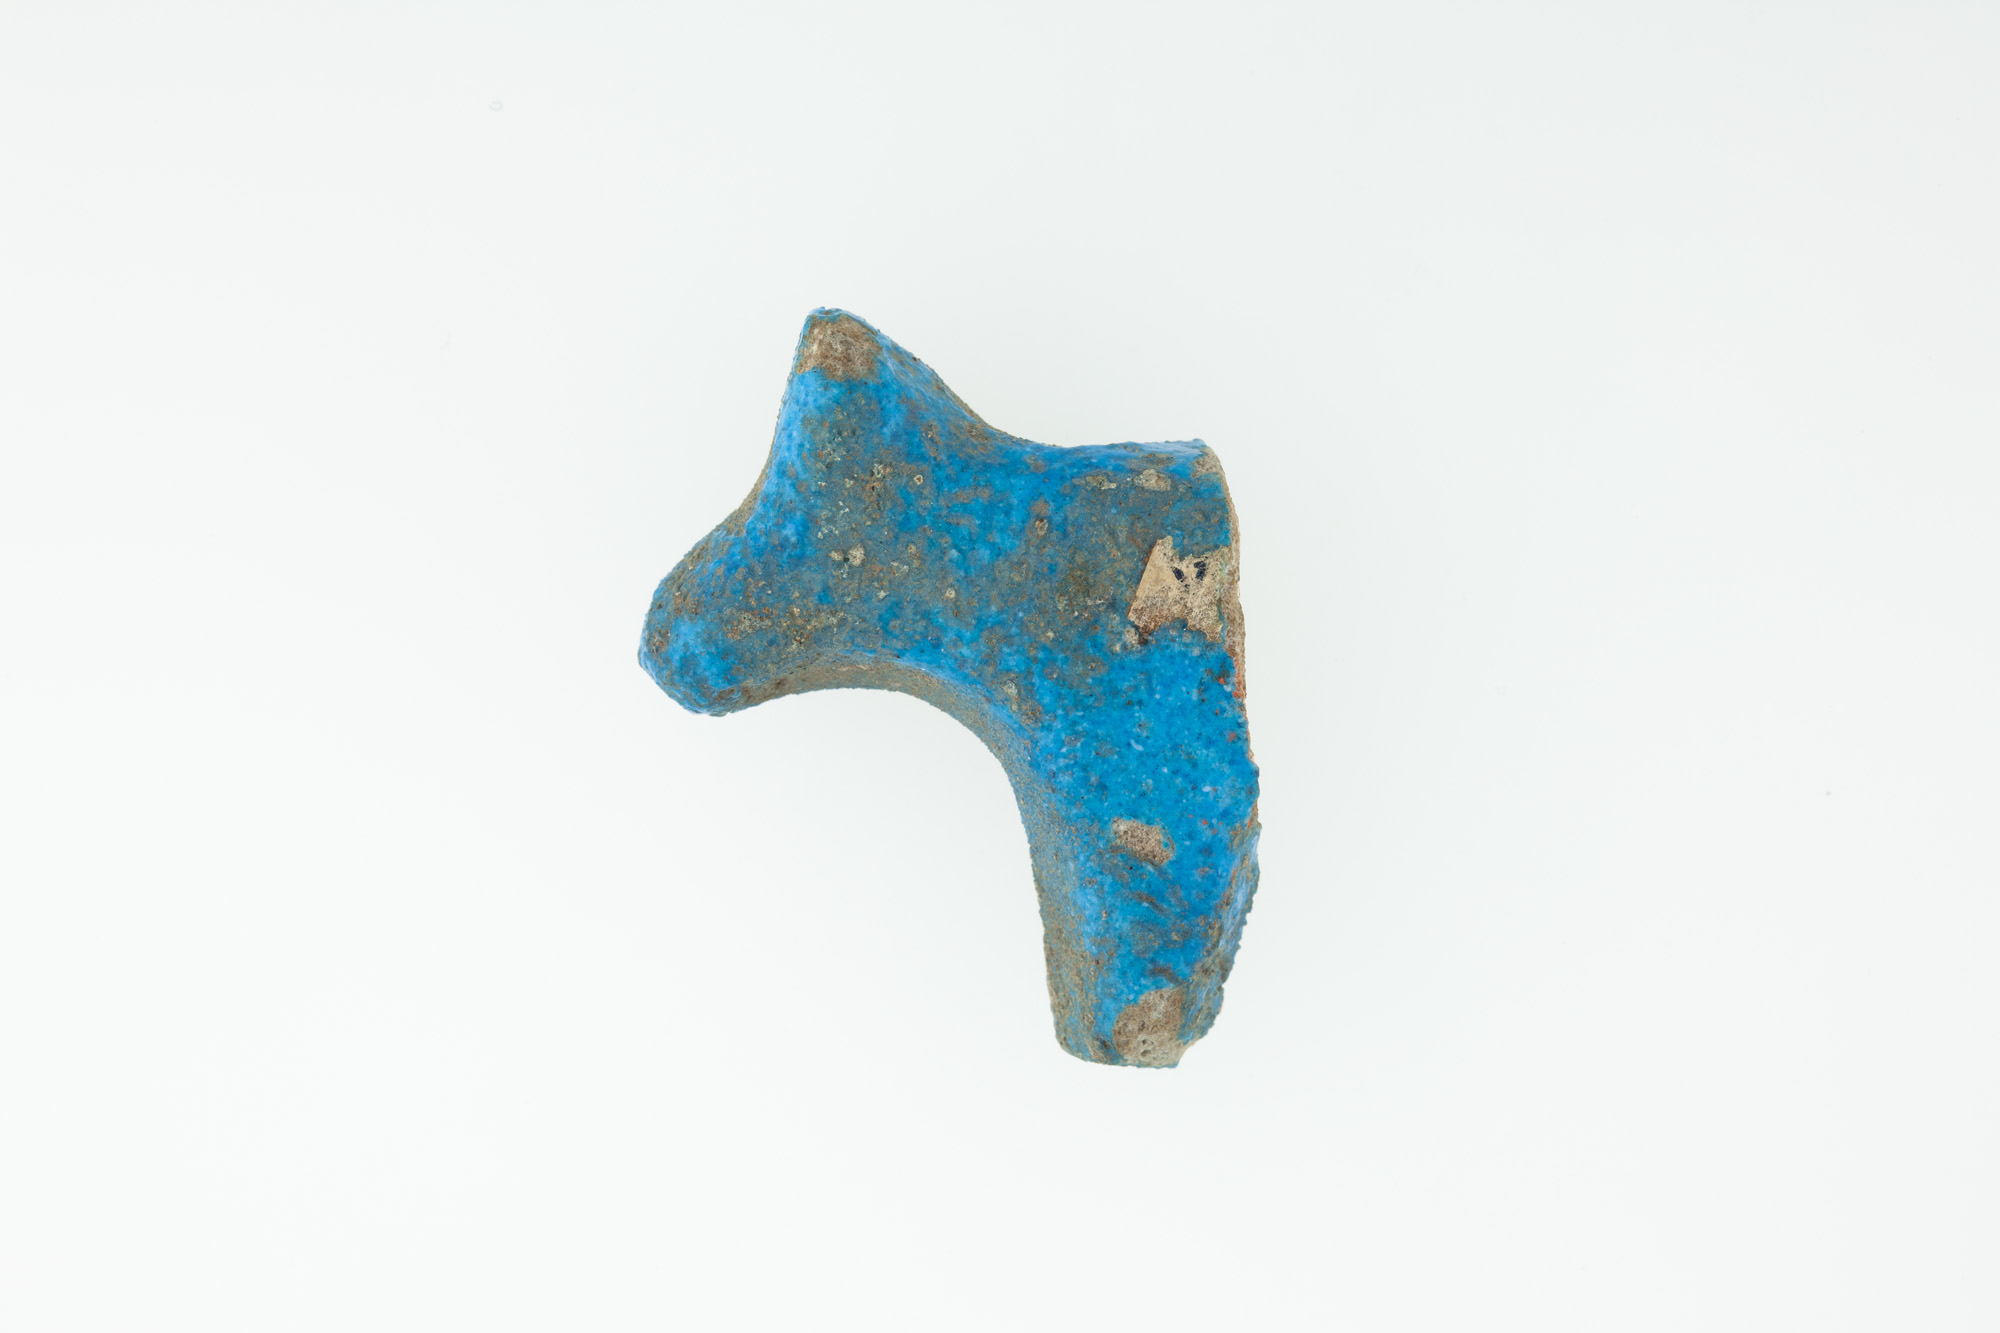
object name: amulet, hathor cow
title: Votive fragment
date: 1479-1458 BCE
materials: faience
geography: egypt